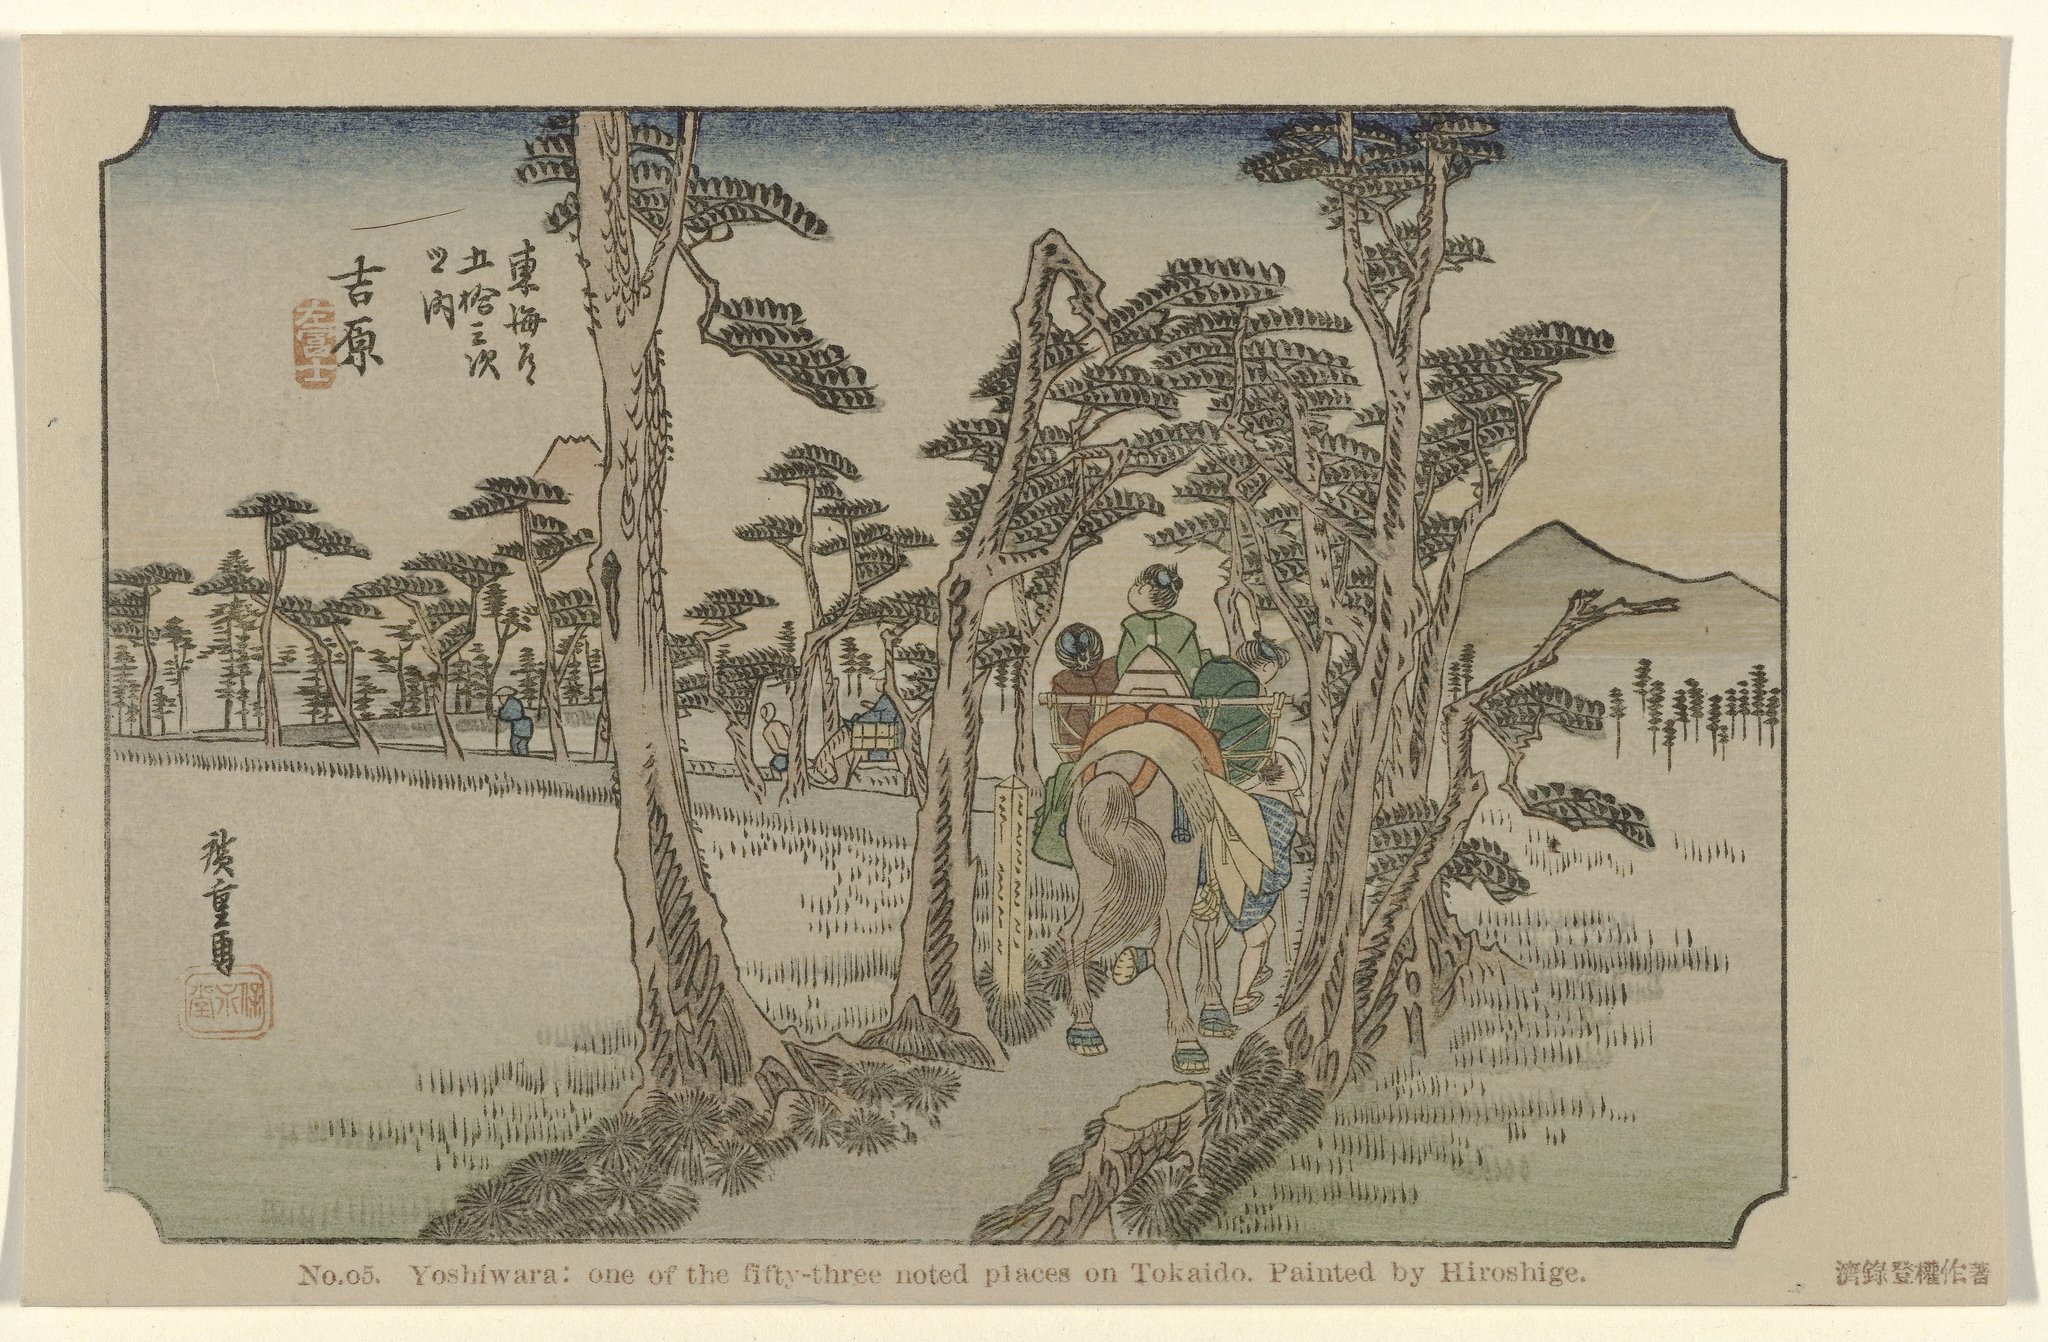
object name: ansichtkaart, prentbriefkaart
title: De Tôkaidô van Hiroshige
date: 1906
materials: cardboard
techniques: woodcut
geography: japan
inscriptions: date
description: Een reizger te paard rijdt over een landweggetje omringt met rijstvelden.